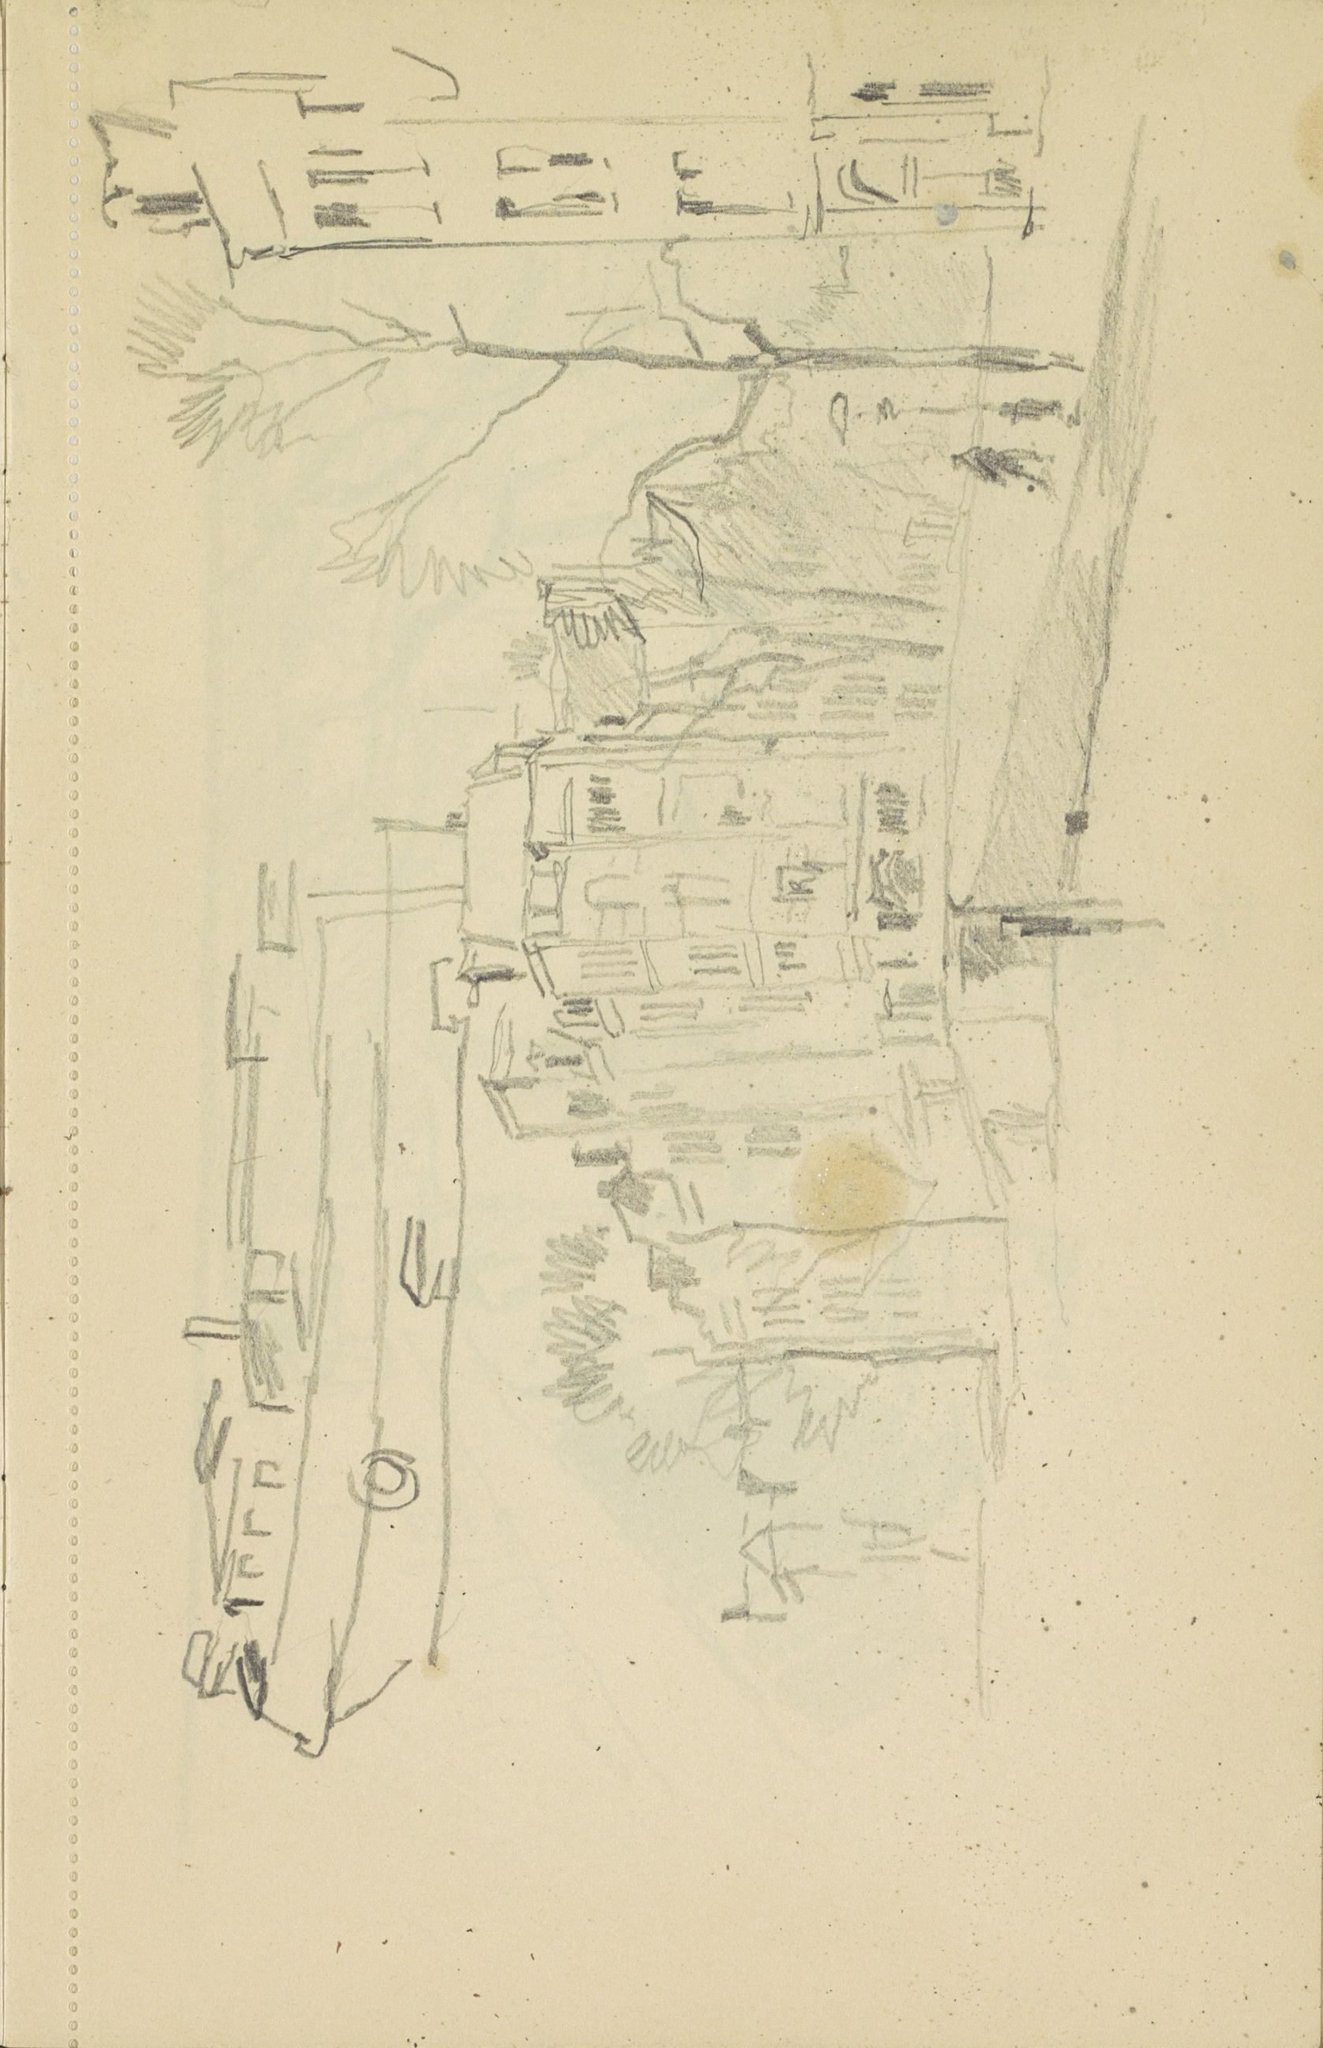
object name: sketchbook leaf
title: Straat langs een gracht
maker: cornelis vreedenburgh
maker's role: draughtsman, print maker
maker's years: 1880-1946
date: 1890-1946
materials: paper, pencil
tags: sailing-ship, sailing-boat, canals, waters (in city), street (+ city(-scape) with figures, staffage)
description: Tevens een studie van een boot. Blad 14 recto uit een schetsboek met 73 bladen.